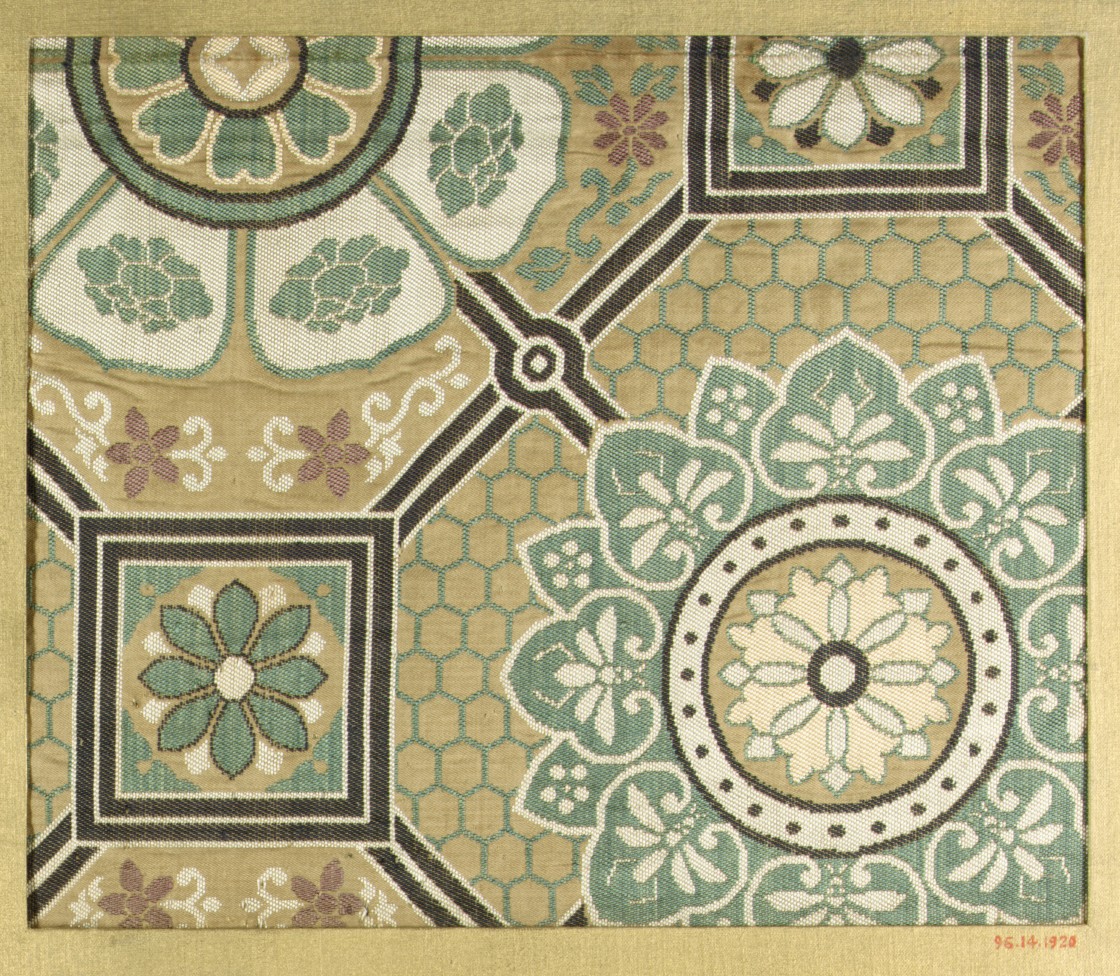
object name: piece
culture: japanese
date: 1701-1900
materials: silk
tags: flowers